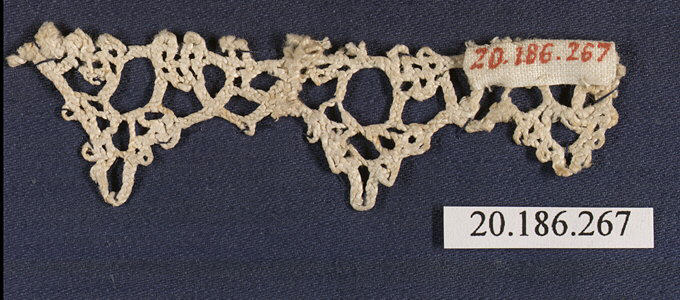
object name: edging fragment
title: Fragment of edging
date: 1501-1600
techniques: lace